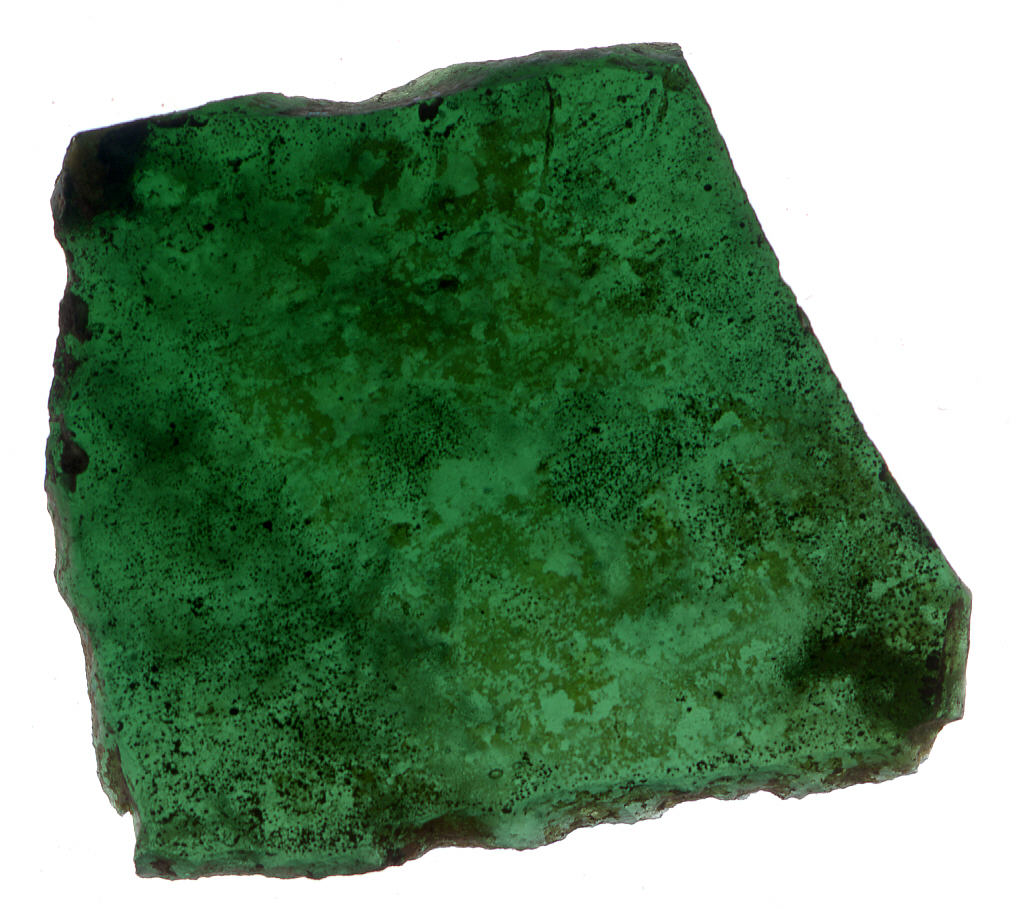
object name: fragment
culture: crusader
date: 1201-1300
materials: glass